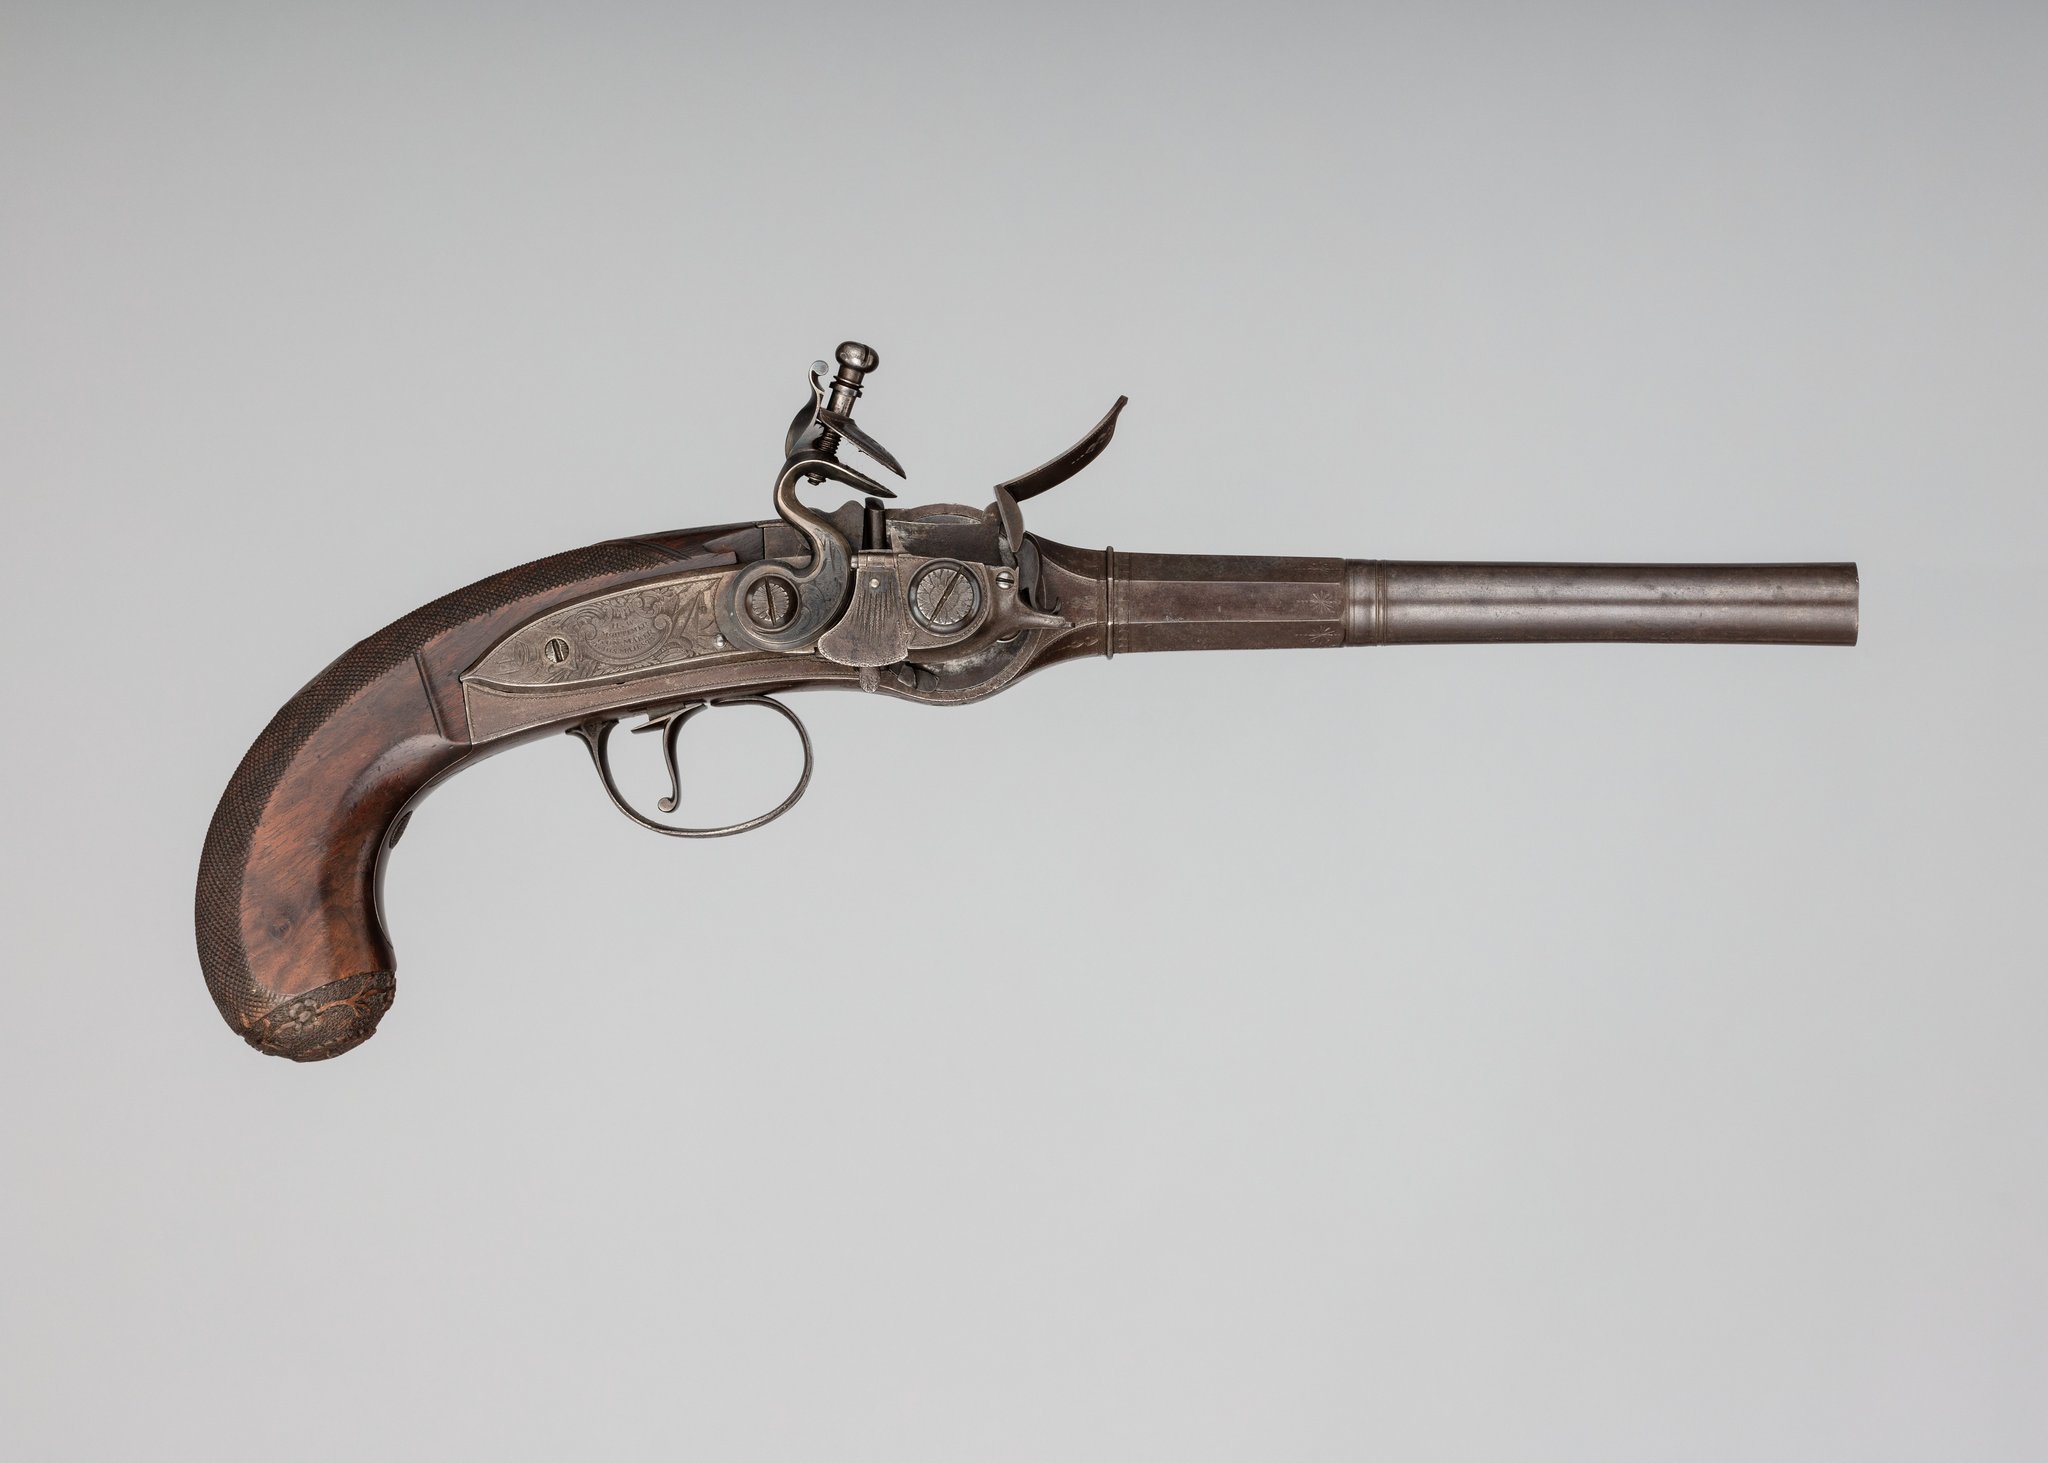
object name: flintlock pistol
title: Flintlock Repeating Pistol with Lorenzoni Action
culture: british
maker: harvey walklate mortimer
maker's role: gunsmith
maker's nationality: british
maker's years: 1753-1819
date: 1783-1800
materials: silver, steel, wood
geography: england